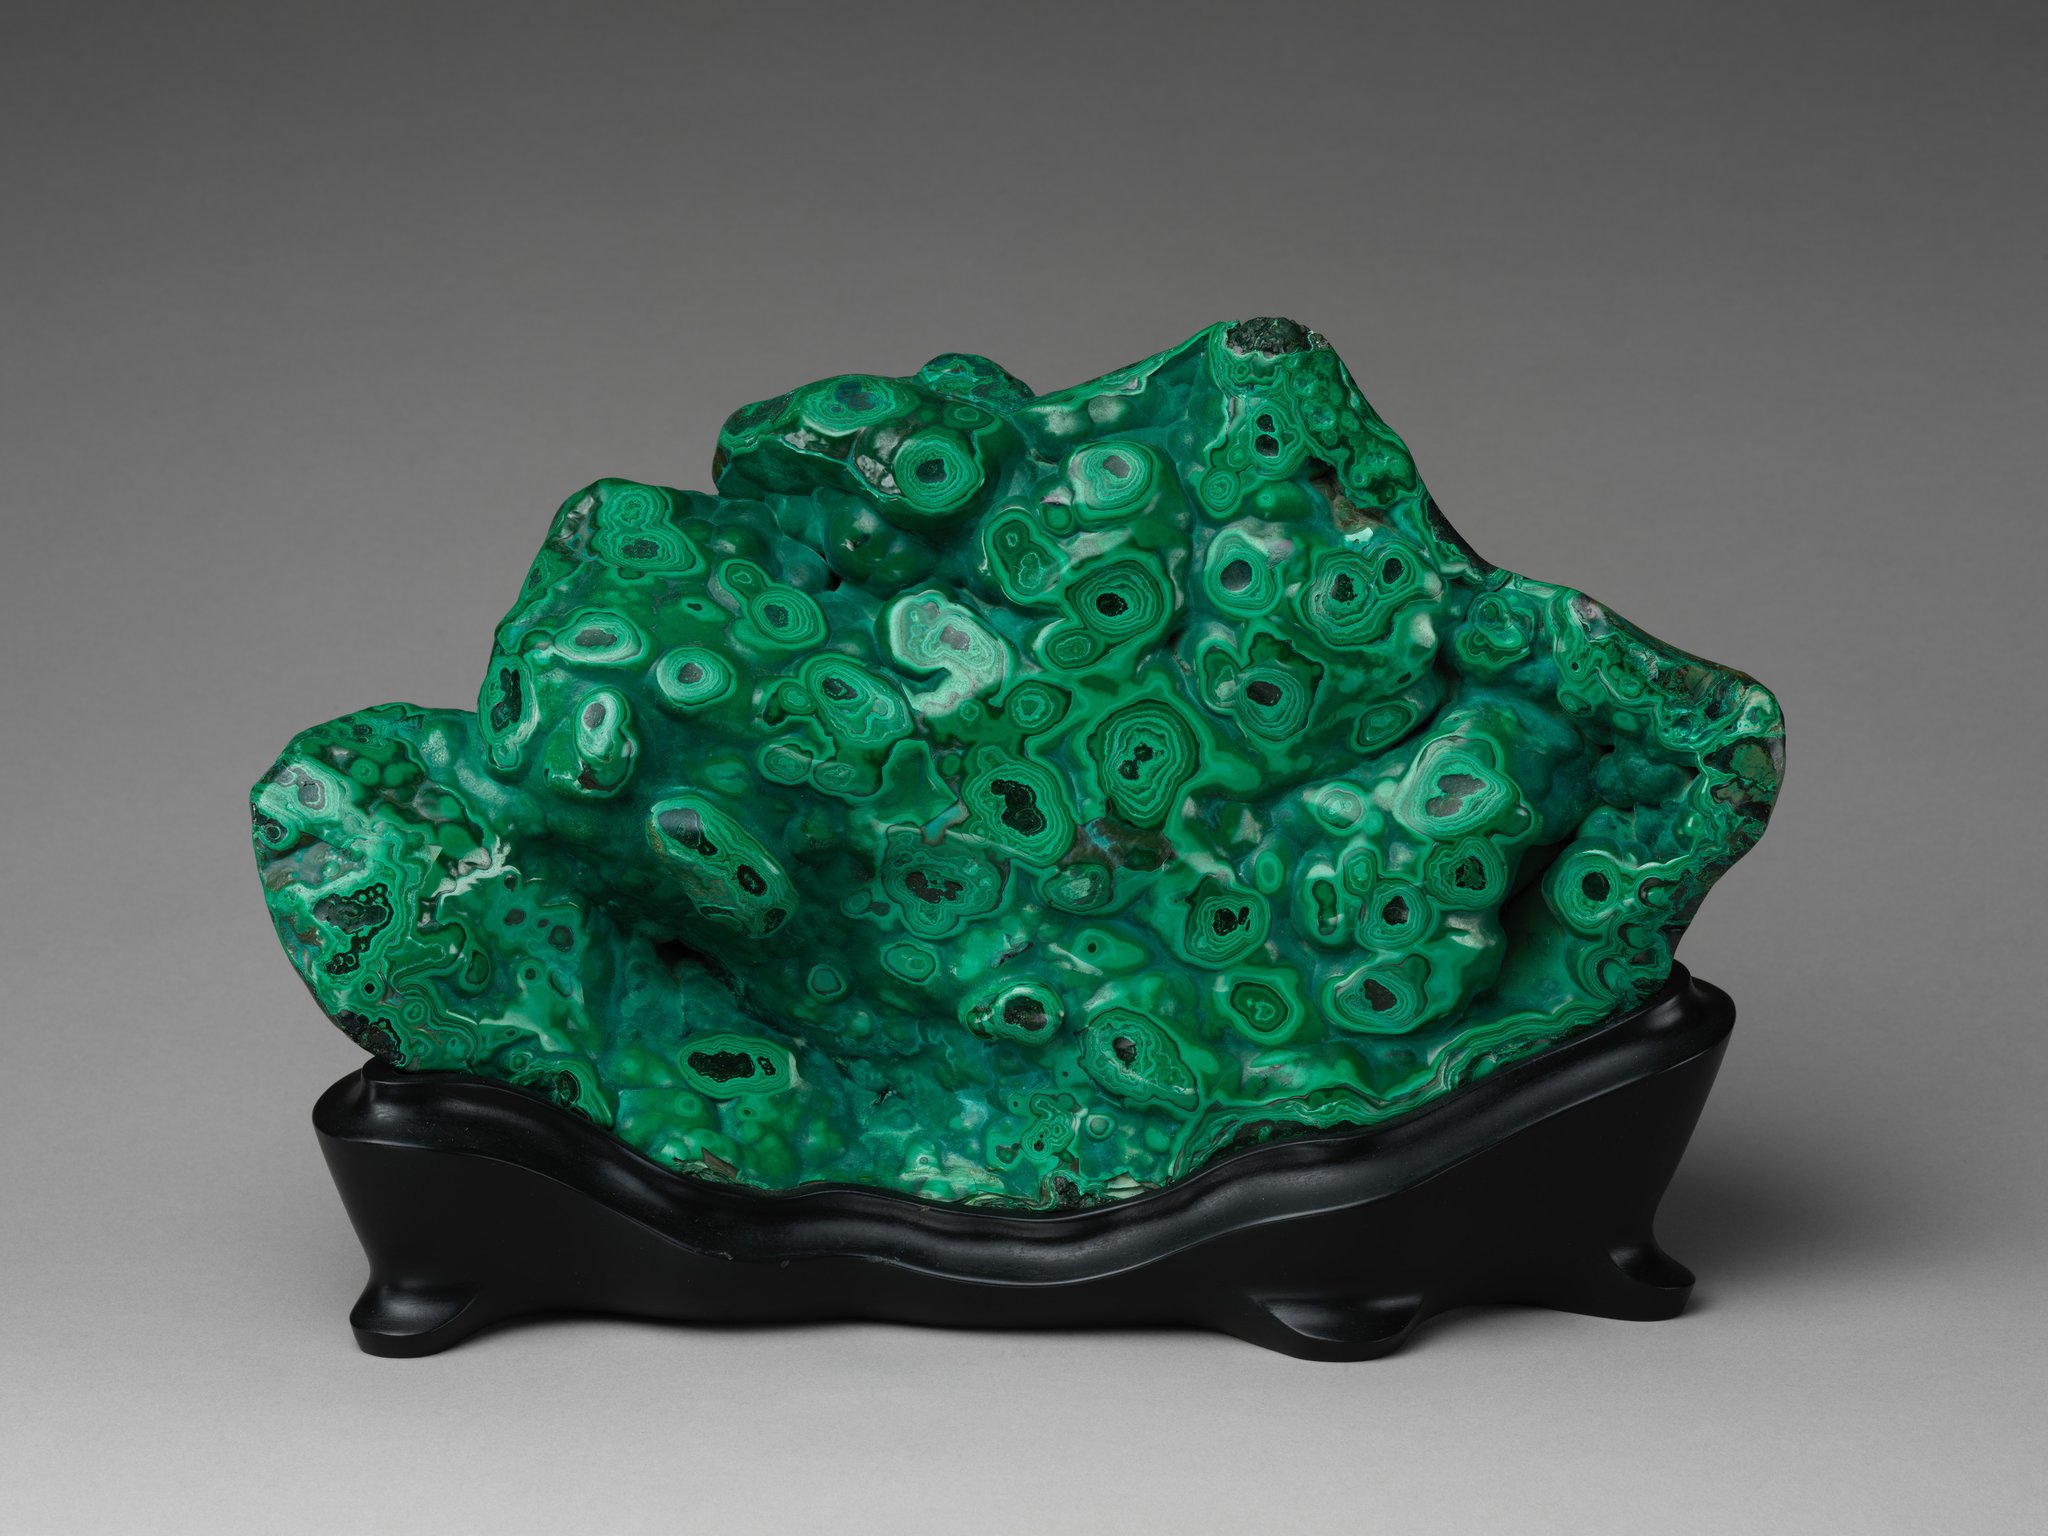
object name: scholar's rock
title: Scholar’s Rock in the Form of a Fantastic Mountain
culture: chinese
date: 1801-2000